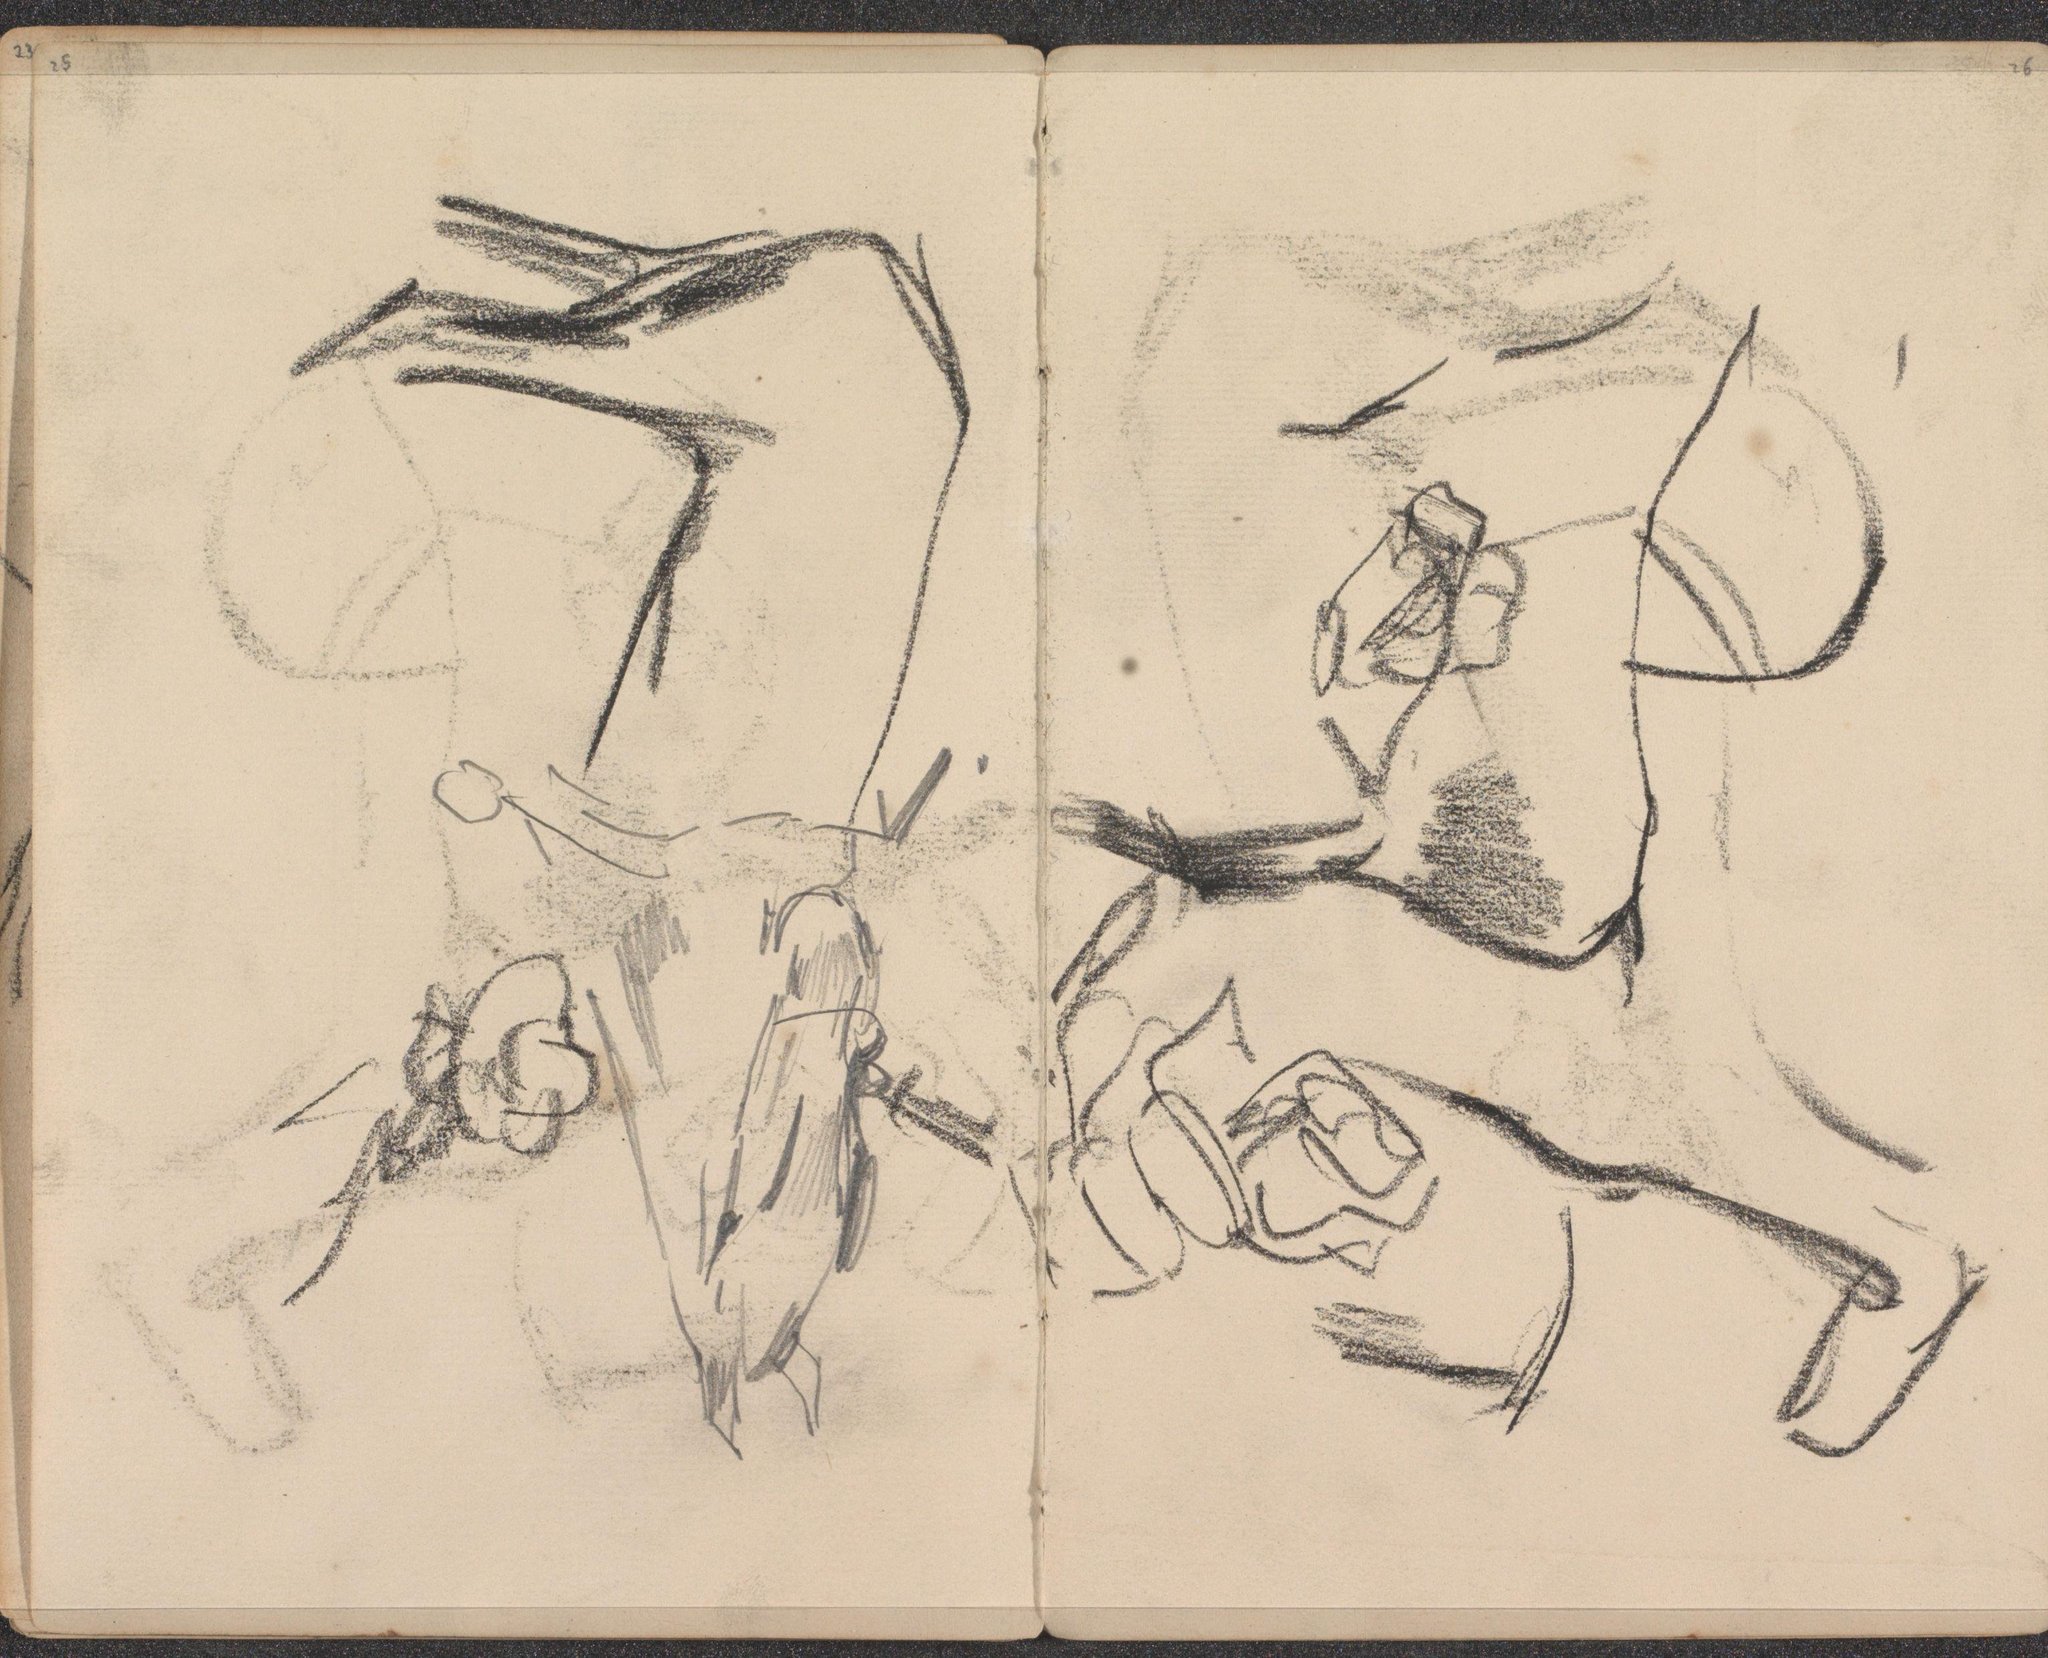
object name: sketchbook leaf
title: Paarden en figuren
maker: george hendrik breitner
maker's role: draughtsman, painter, print maker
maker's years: 1857-1923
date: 1886-1923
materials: chalk, paper, pencil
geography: amsterdam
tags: adult woman, adult man, horse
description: Pagina 25 uit een schetsboek met 17 bladen.